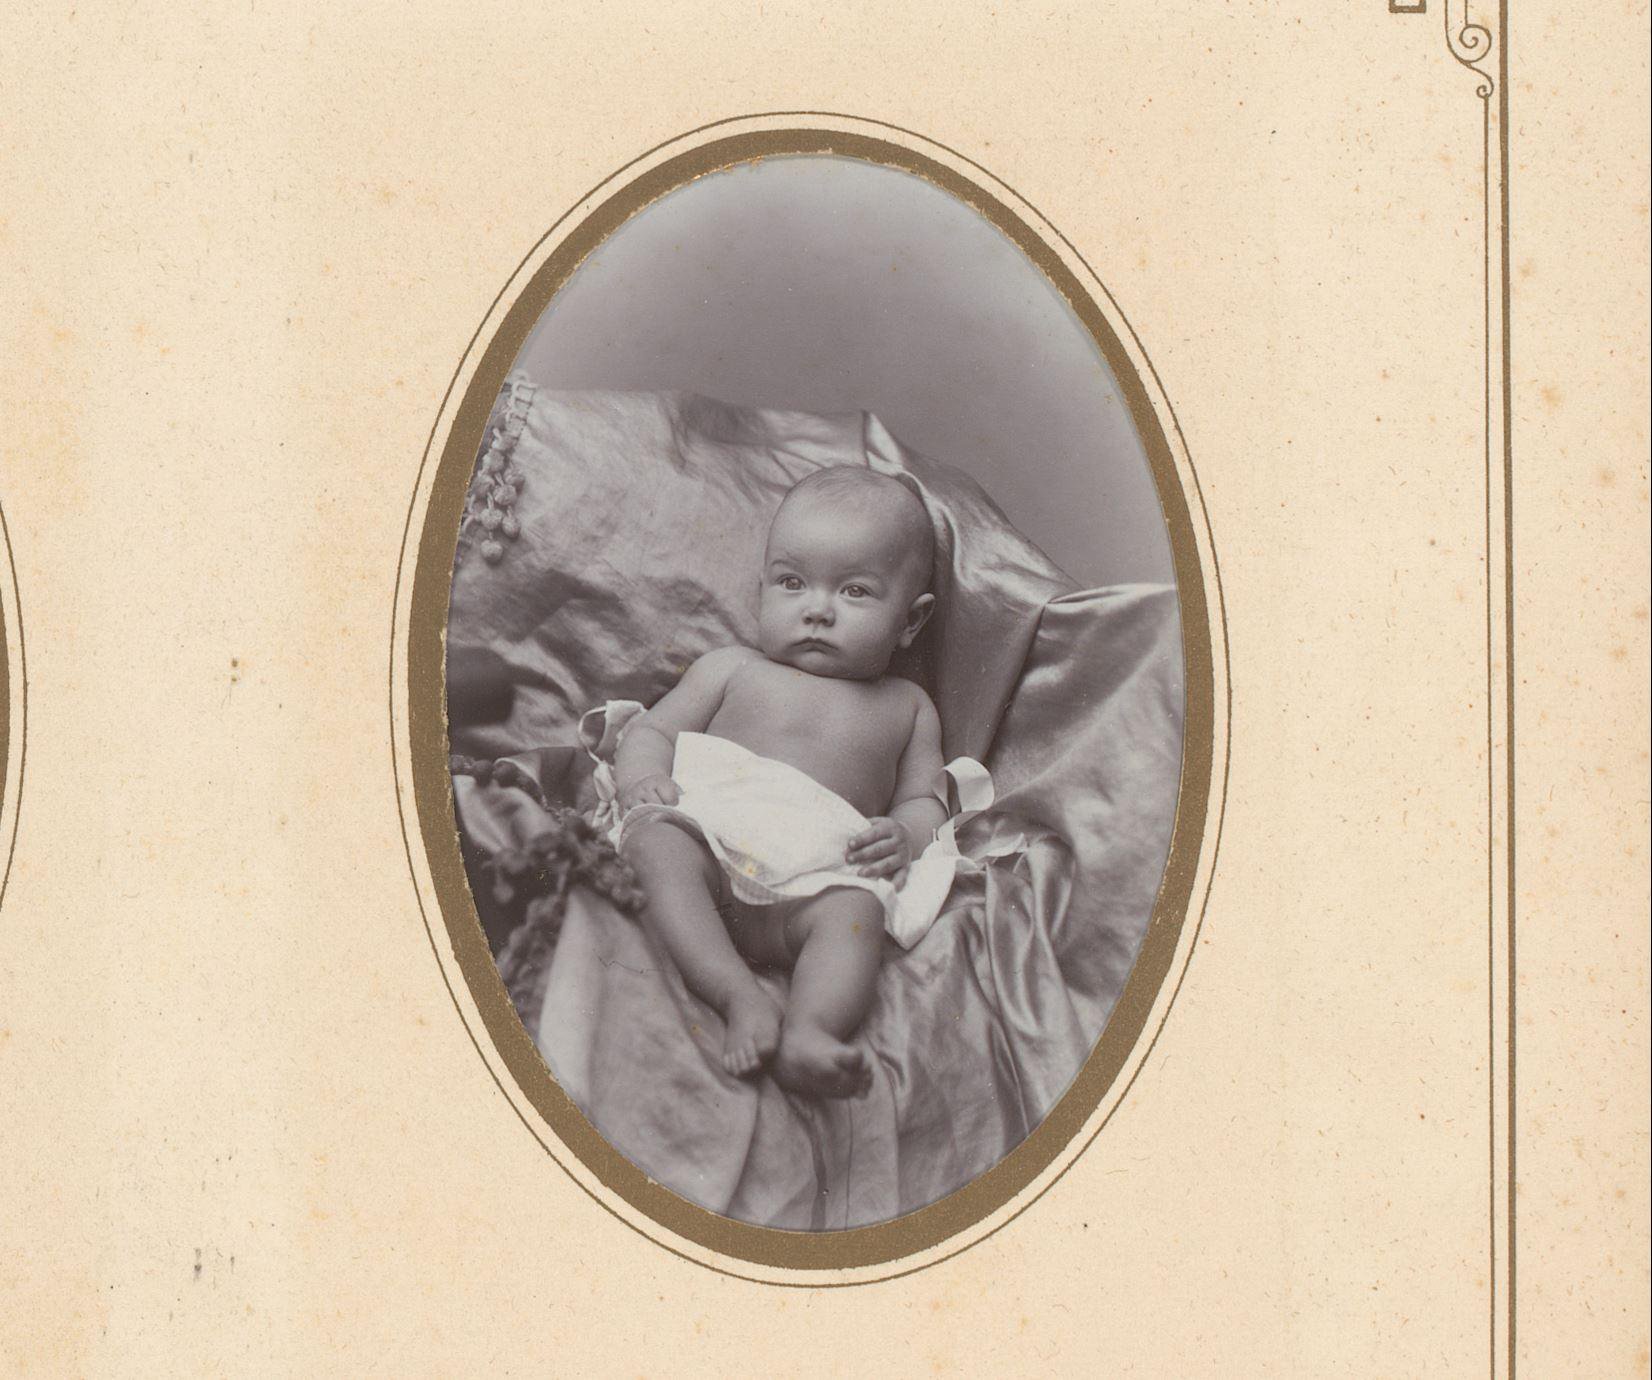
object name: carte de visite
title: Portret van een baby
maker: victor angerer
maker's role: publisher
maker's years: 1839-1924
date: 1870-1910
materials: cardboard, photographic support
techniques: collodion silver print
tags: historical persons, infant, baby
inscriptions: inscription: ‘Photographische Kunstanstalt/ Victor/ Angerer/ KuK Hof/ Photograph/ Ateliers/ IX Waisenhausglasse 16/ (...)’